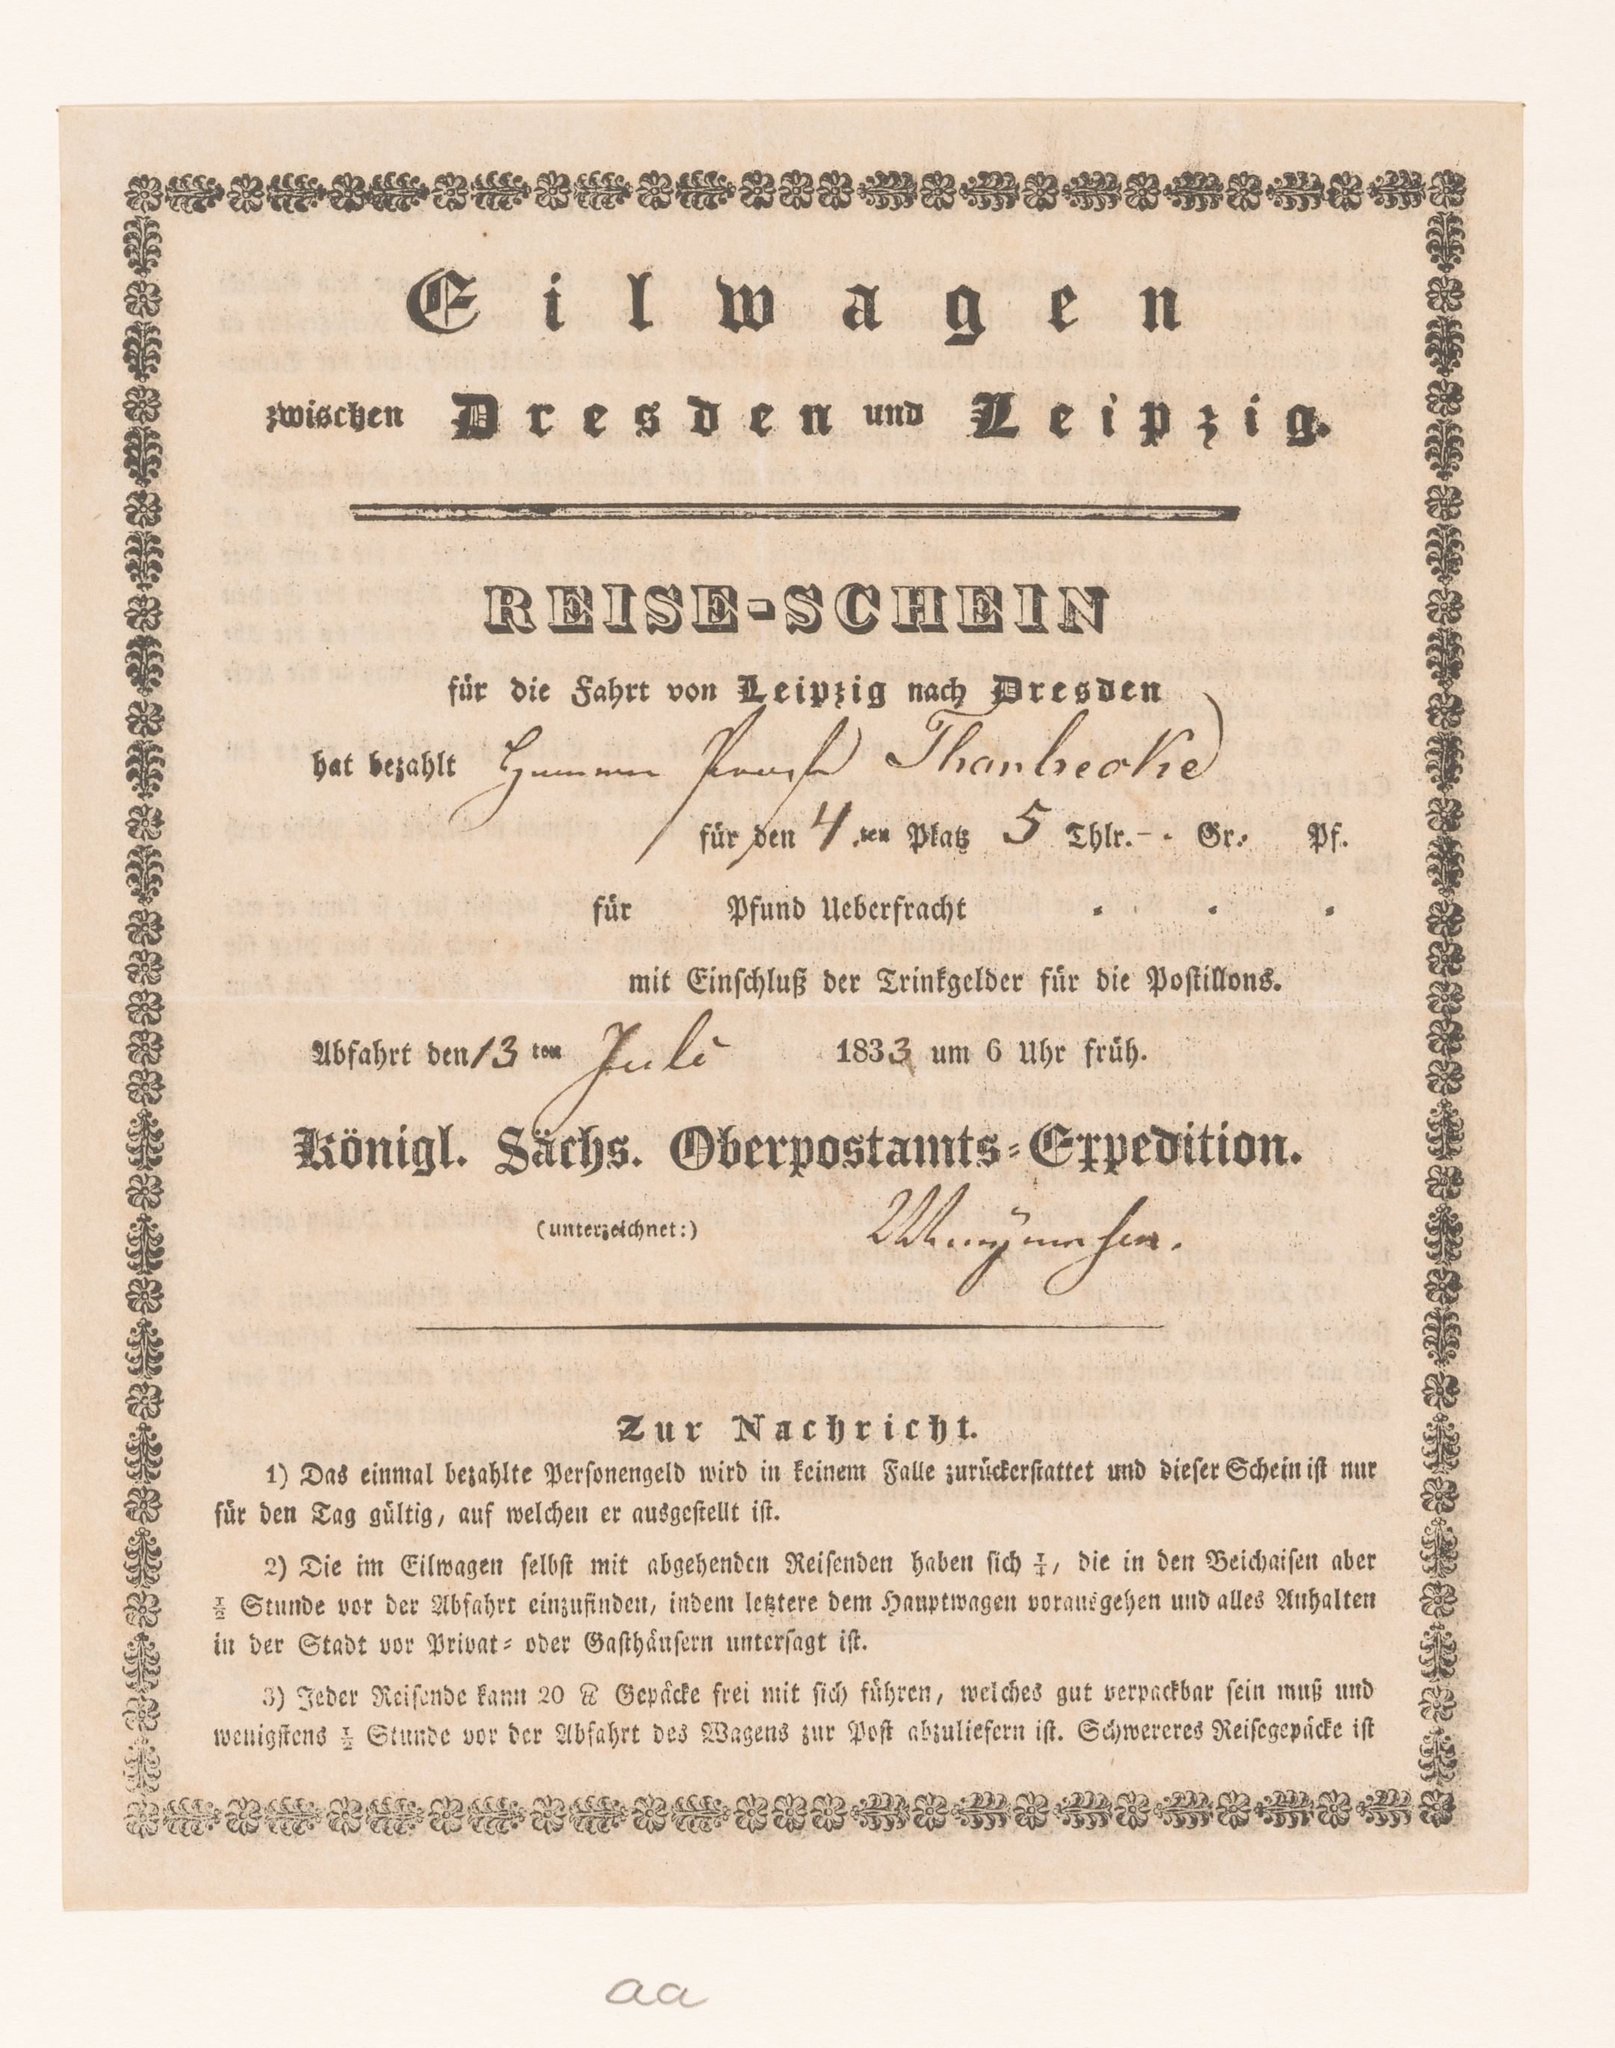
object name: travel document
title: Document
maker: Anonymous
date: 1833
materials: paper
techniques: printing, writing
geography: germany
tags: the hague, johan rudolf thorbecke, germany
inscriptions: date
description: Reise-Schein Eilwagen Leipzig-Dresden. Gedateerd: 13 juli 1833.